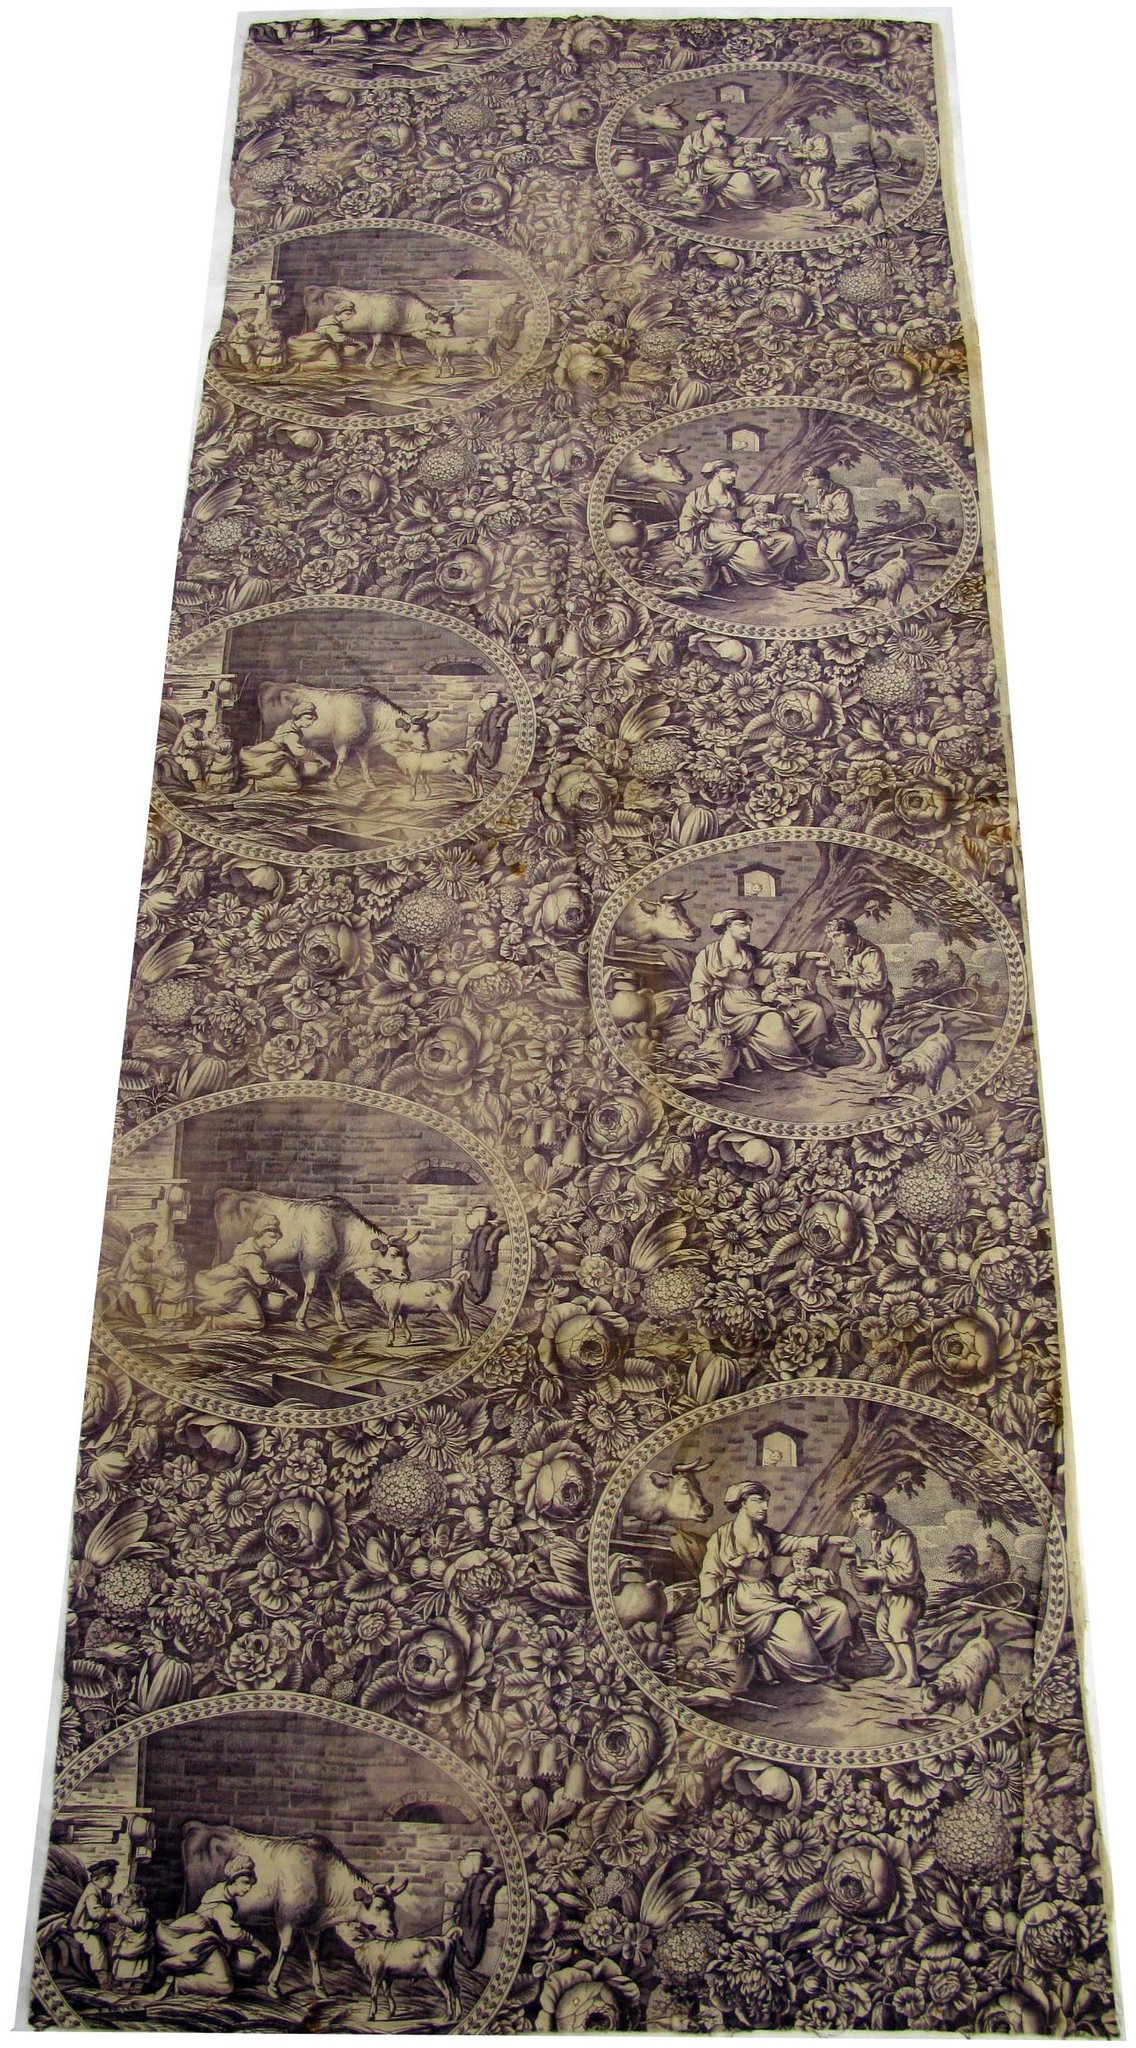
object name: length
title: Farm scenes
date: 1820-1829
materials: cotton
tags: farms,men,women,cows,roses